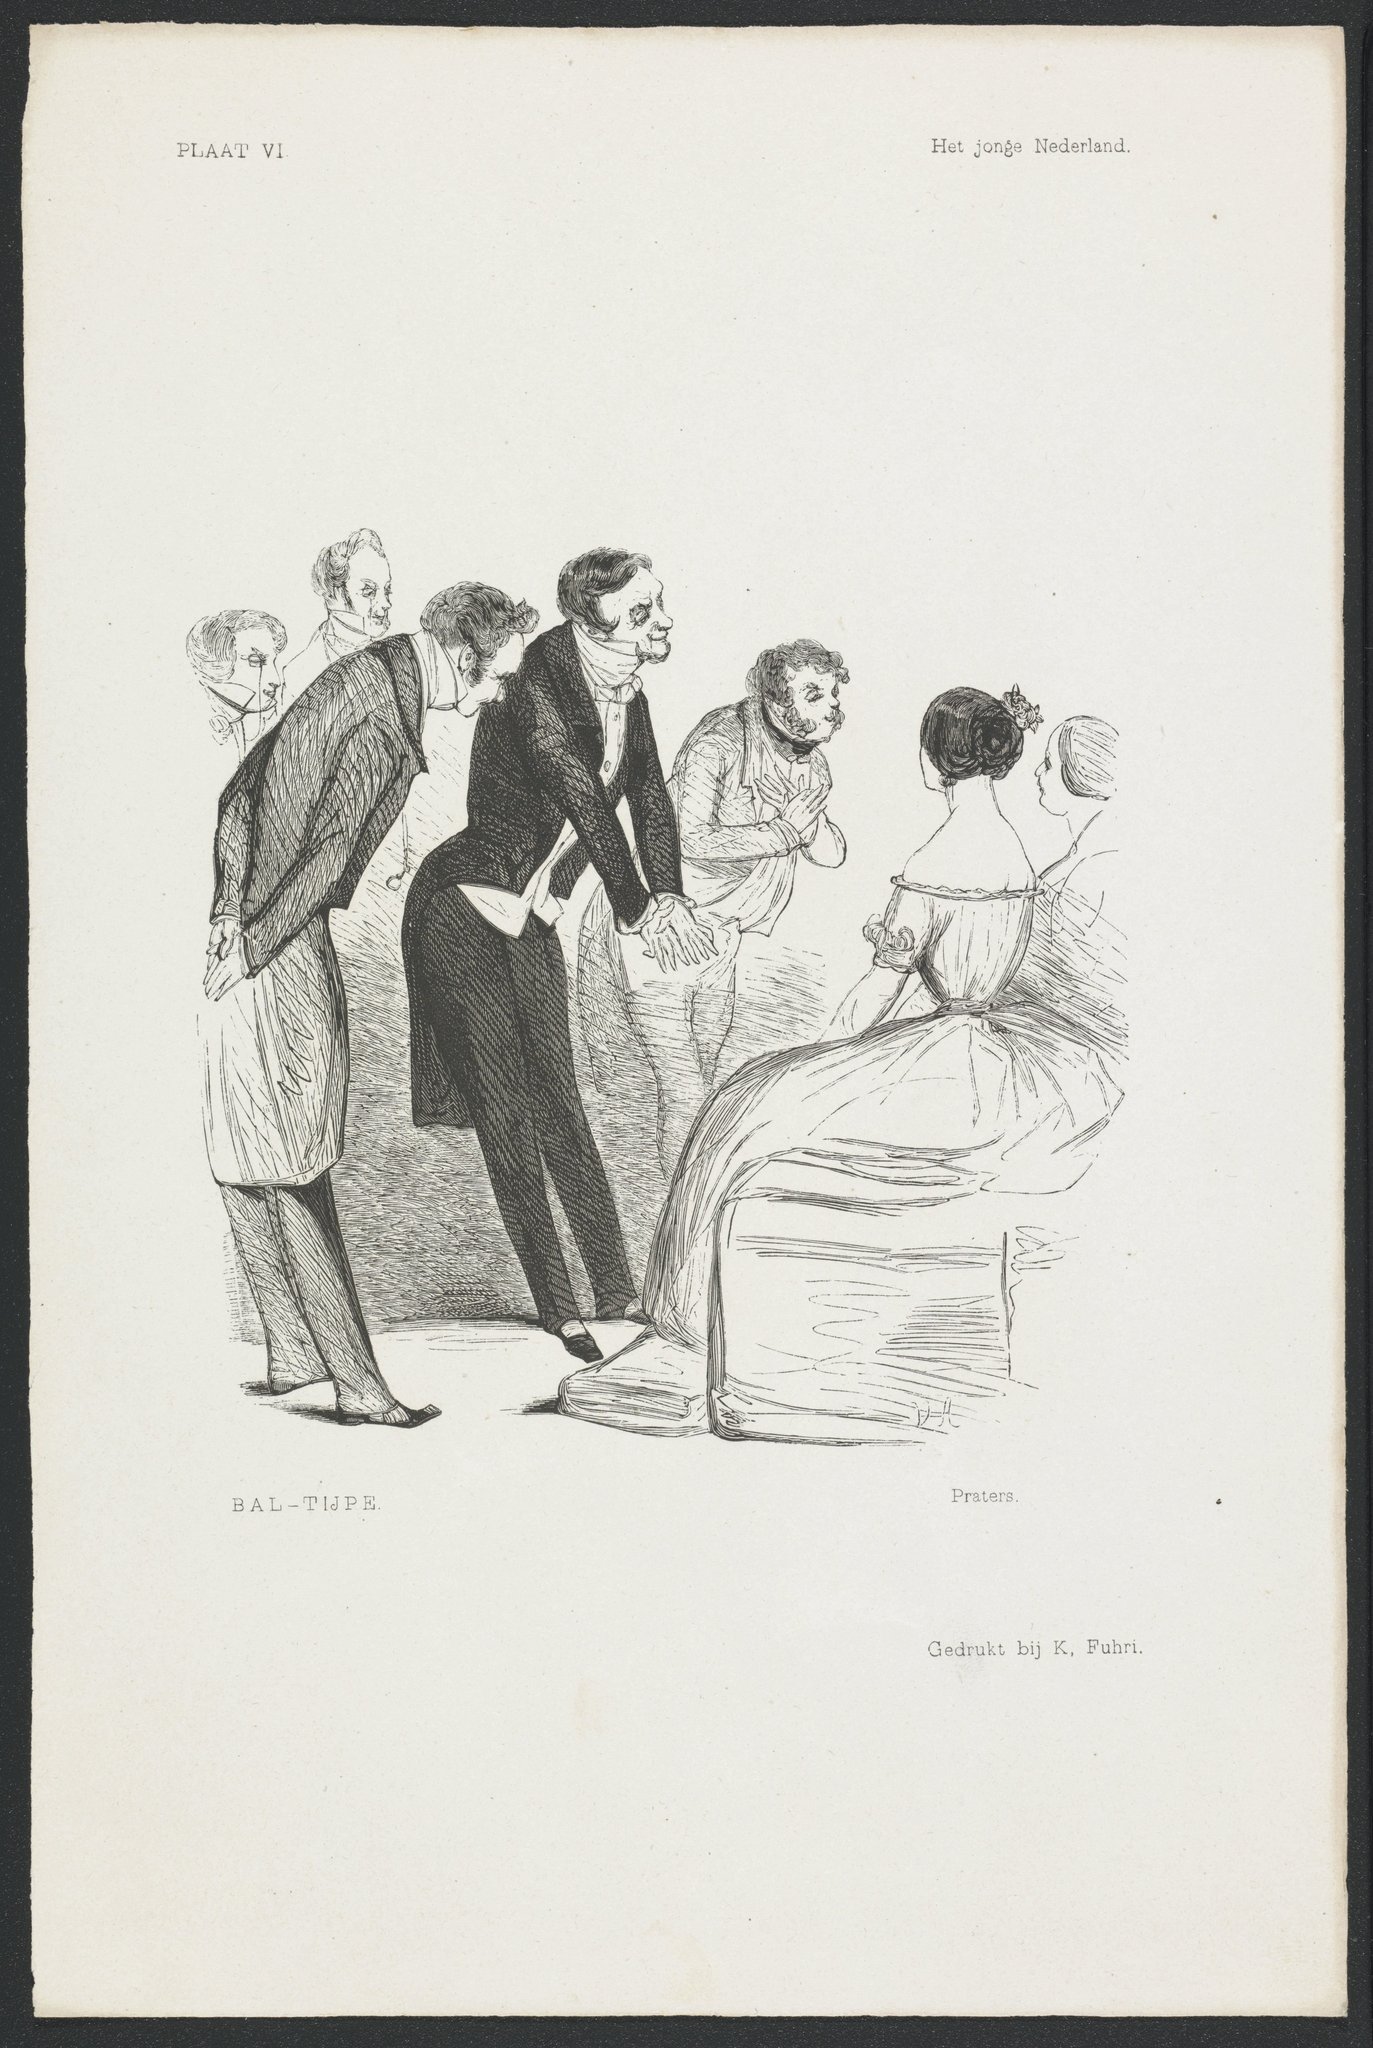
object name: print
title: Bal-tijpe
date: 1847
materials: paper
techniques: letterpress printing, engraving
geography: the hague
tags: ball, formal dance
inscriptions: collector's mark: Lugt 2228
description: Twee vrouwen worden door meerdere mannen ten dans gevraagd. In de ondermarge een woord Nederlandse tekst in boekdruk.